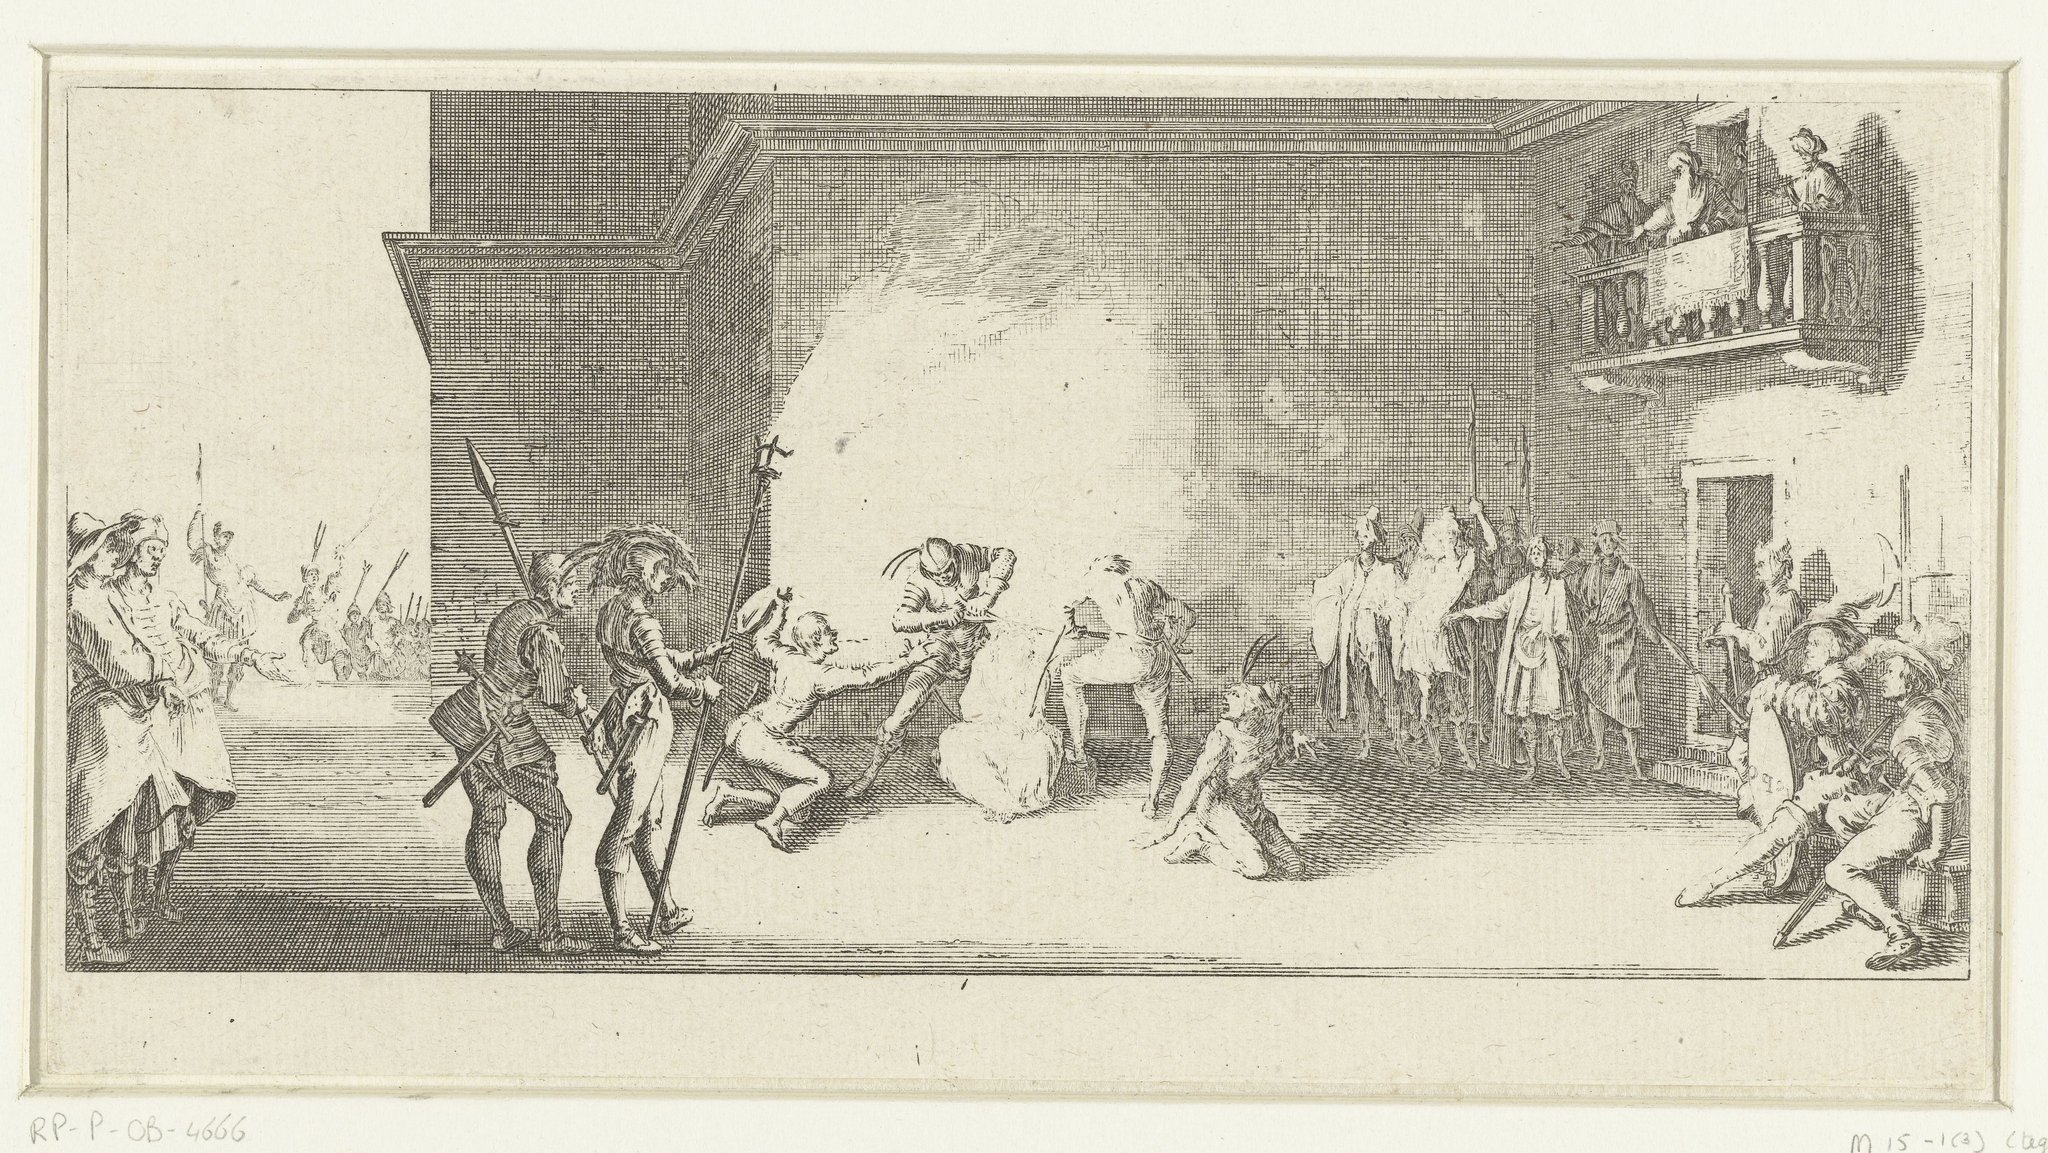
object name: print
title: Doornenkroning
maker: jacques callot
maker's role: draughtsman, print maker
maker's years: 1592-1635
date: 1619-1624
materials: paper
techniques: printmaking, engraving, etching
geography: florence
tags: the crowning with thorns: soldiers with sticks place a thorny crown on christ's head and give him a reed (matthew 27:27-31; mark 15:16-20; john 19:2-3)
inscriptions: collector's mark: Lugt 240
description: Soldaten duwen Christus, zittend voor een gebouw, een doornenkroon op het hoofd. Vanaf een balkon kijken drie mannen toe. Deze prent is een tegenafdruk (contre-épreuve) van een prent die onderdeel is van de onvoltooide prentserie 'De grote Passie', bestaande uit 7 scènes uit het Lijdensverhaal.